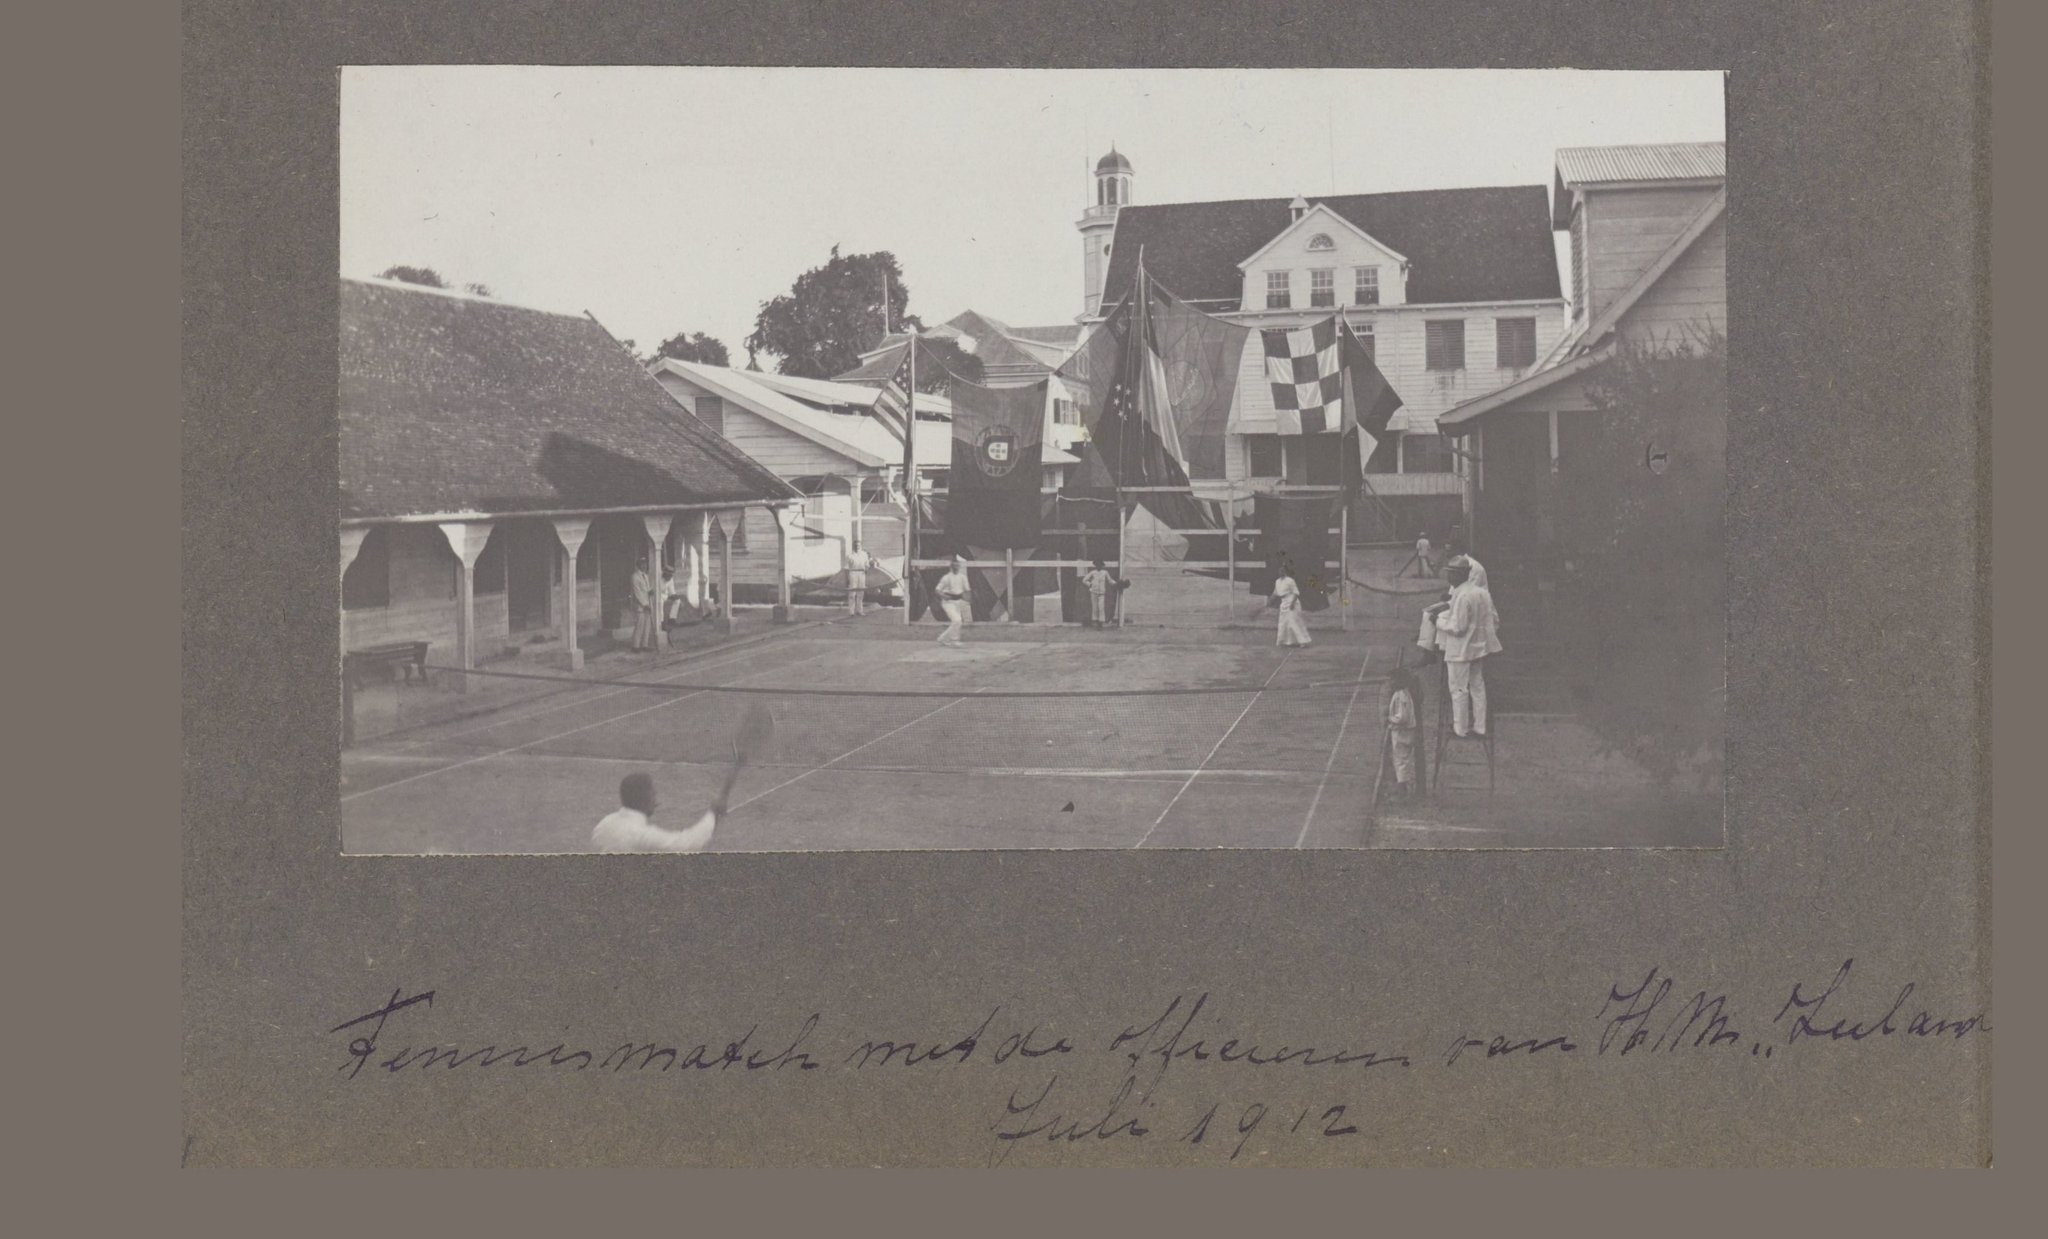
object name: photograph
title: Tennismatch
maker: Anonymous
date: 1907-1912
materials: photographic support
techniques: photography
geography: paramaribo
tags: tennis, lawn-tennis, suriname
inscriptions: inscription: ‘Tennismatch met de officieren van Hr Ms "Zeeland" Juli 1912’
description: Tenniswedstrijd met de officieren van het Pantserdekschip Hr. Ms. Zeeland op de tennisclub in Paramaribo, juli 1912. Onderdeel van het fotoalbum over het leven van de familie Gonggrijp in Suriname rond 1912.